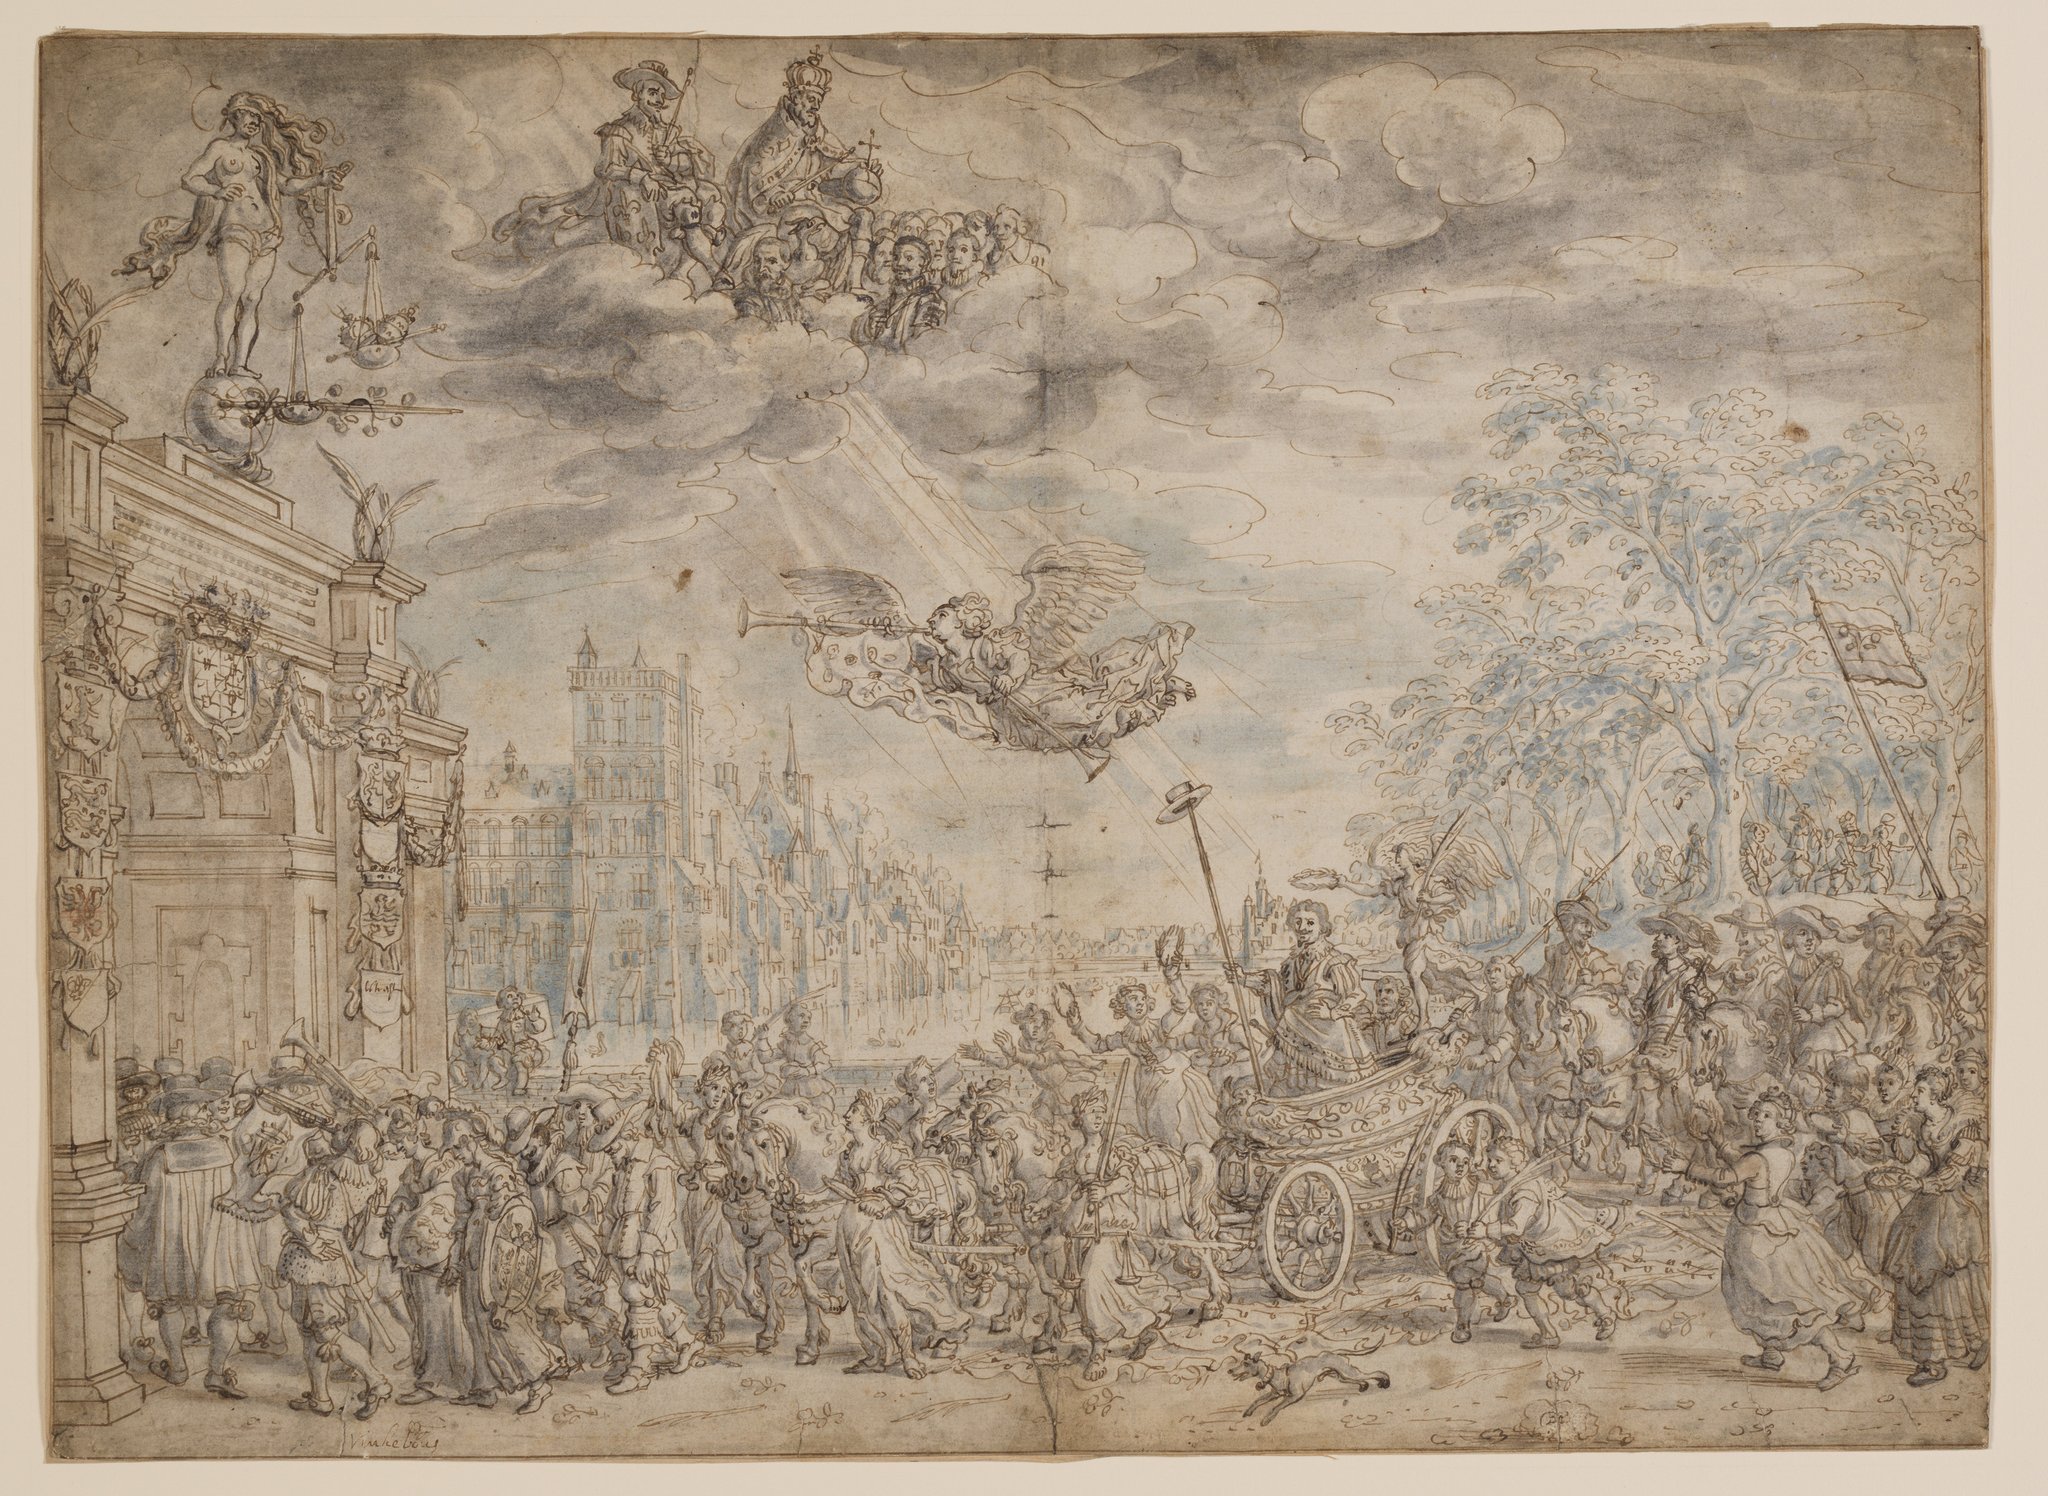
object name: drawing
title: The Triumphal Entry of Frederik Hendrik of the Orange into The Hague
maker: david vinckboons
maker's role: artist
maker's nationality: netherlandish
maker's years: 1576-1629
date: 1629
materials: chalk, ink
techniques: pen, wash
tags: men,women,horses,angels